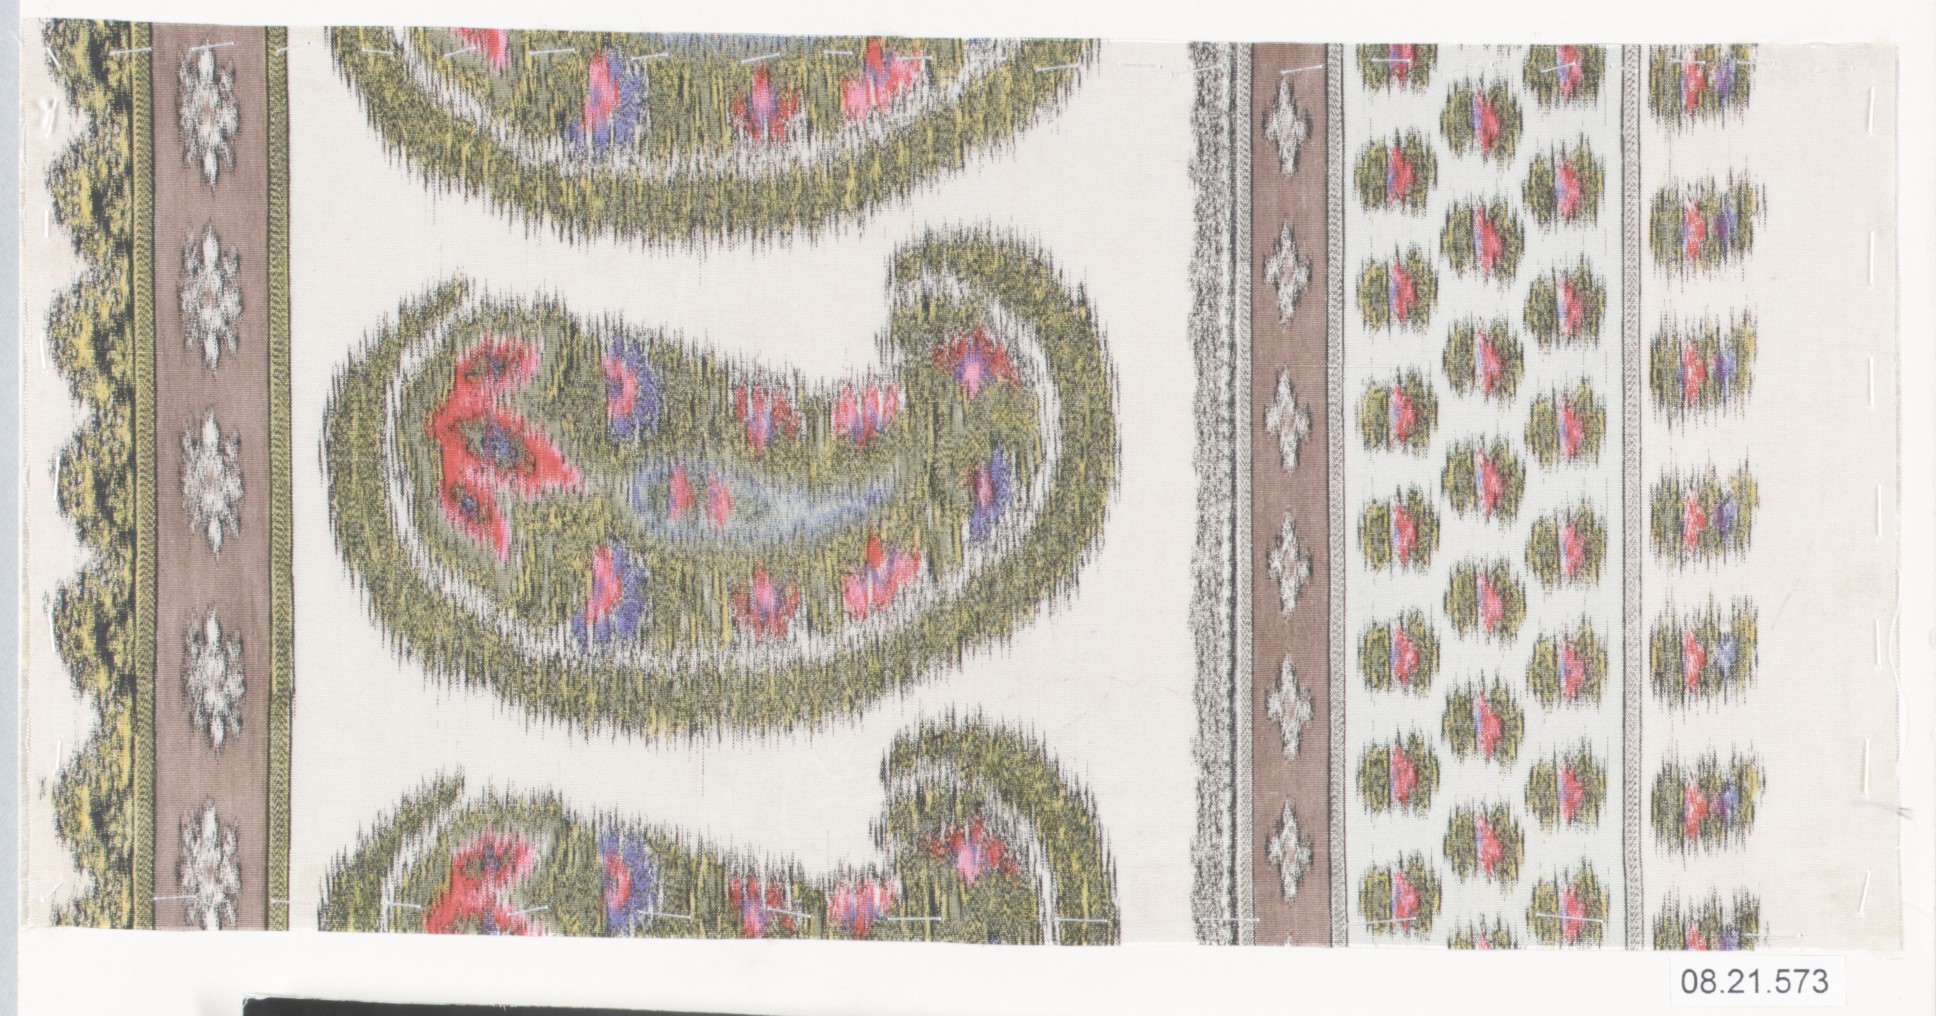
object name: textile sample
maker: Anonymous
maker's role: designer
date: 1900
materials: silk